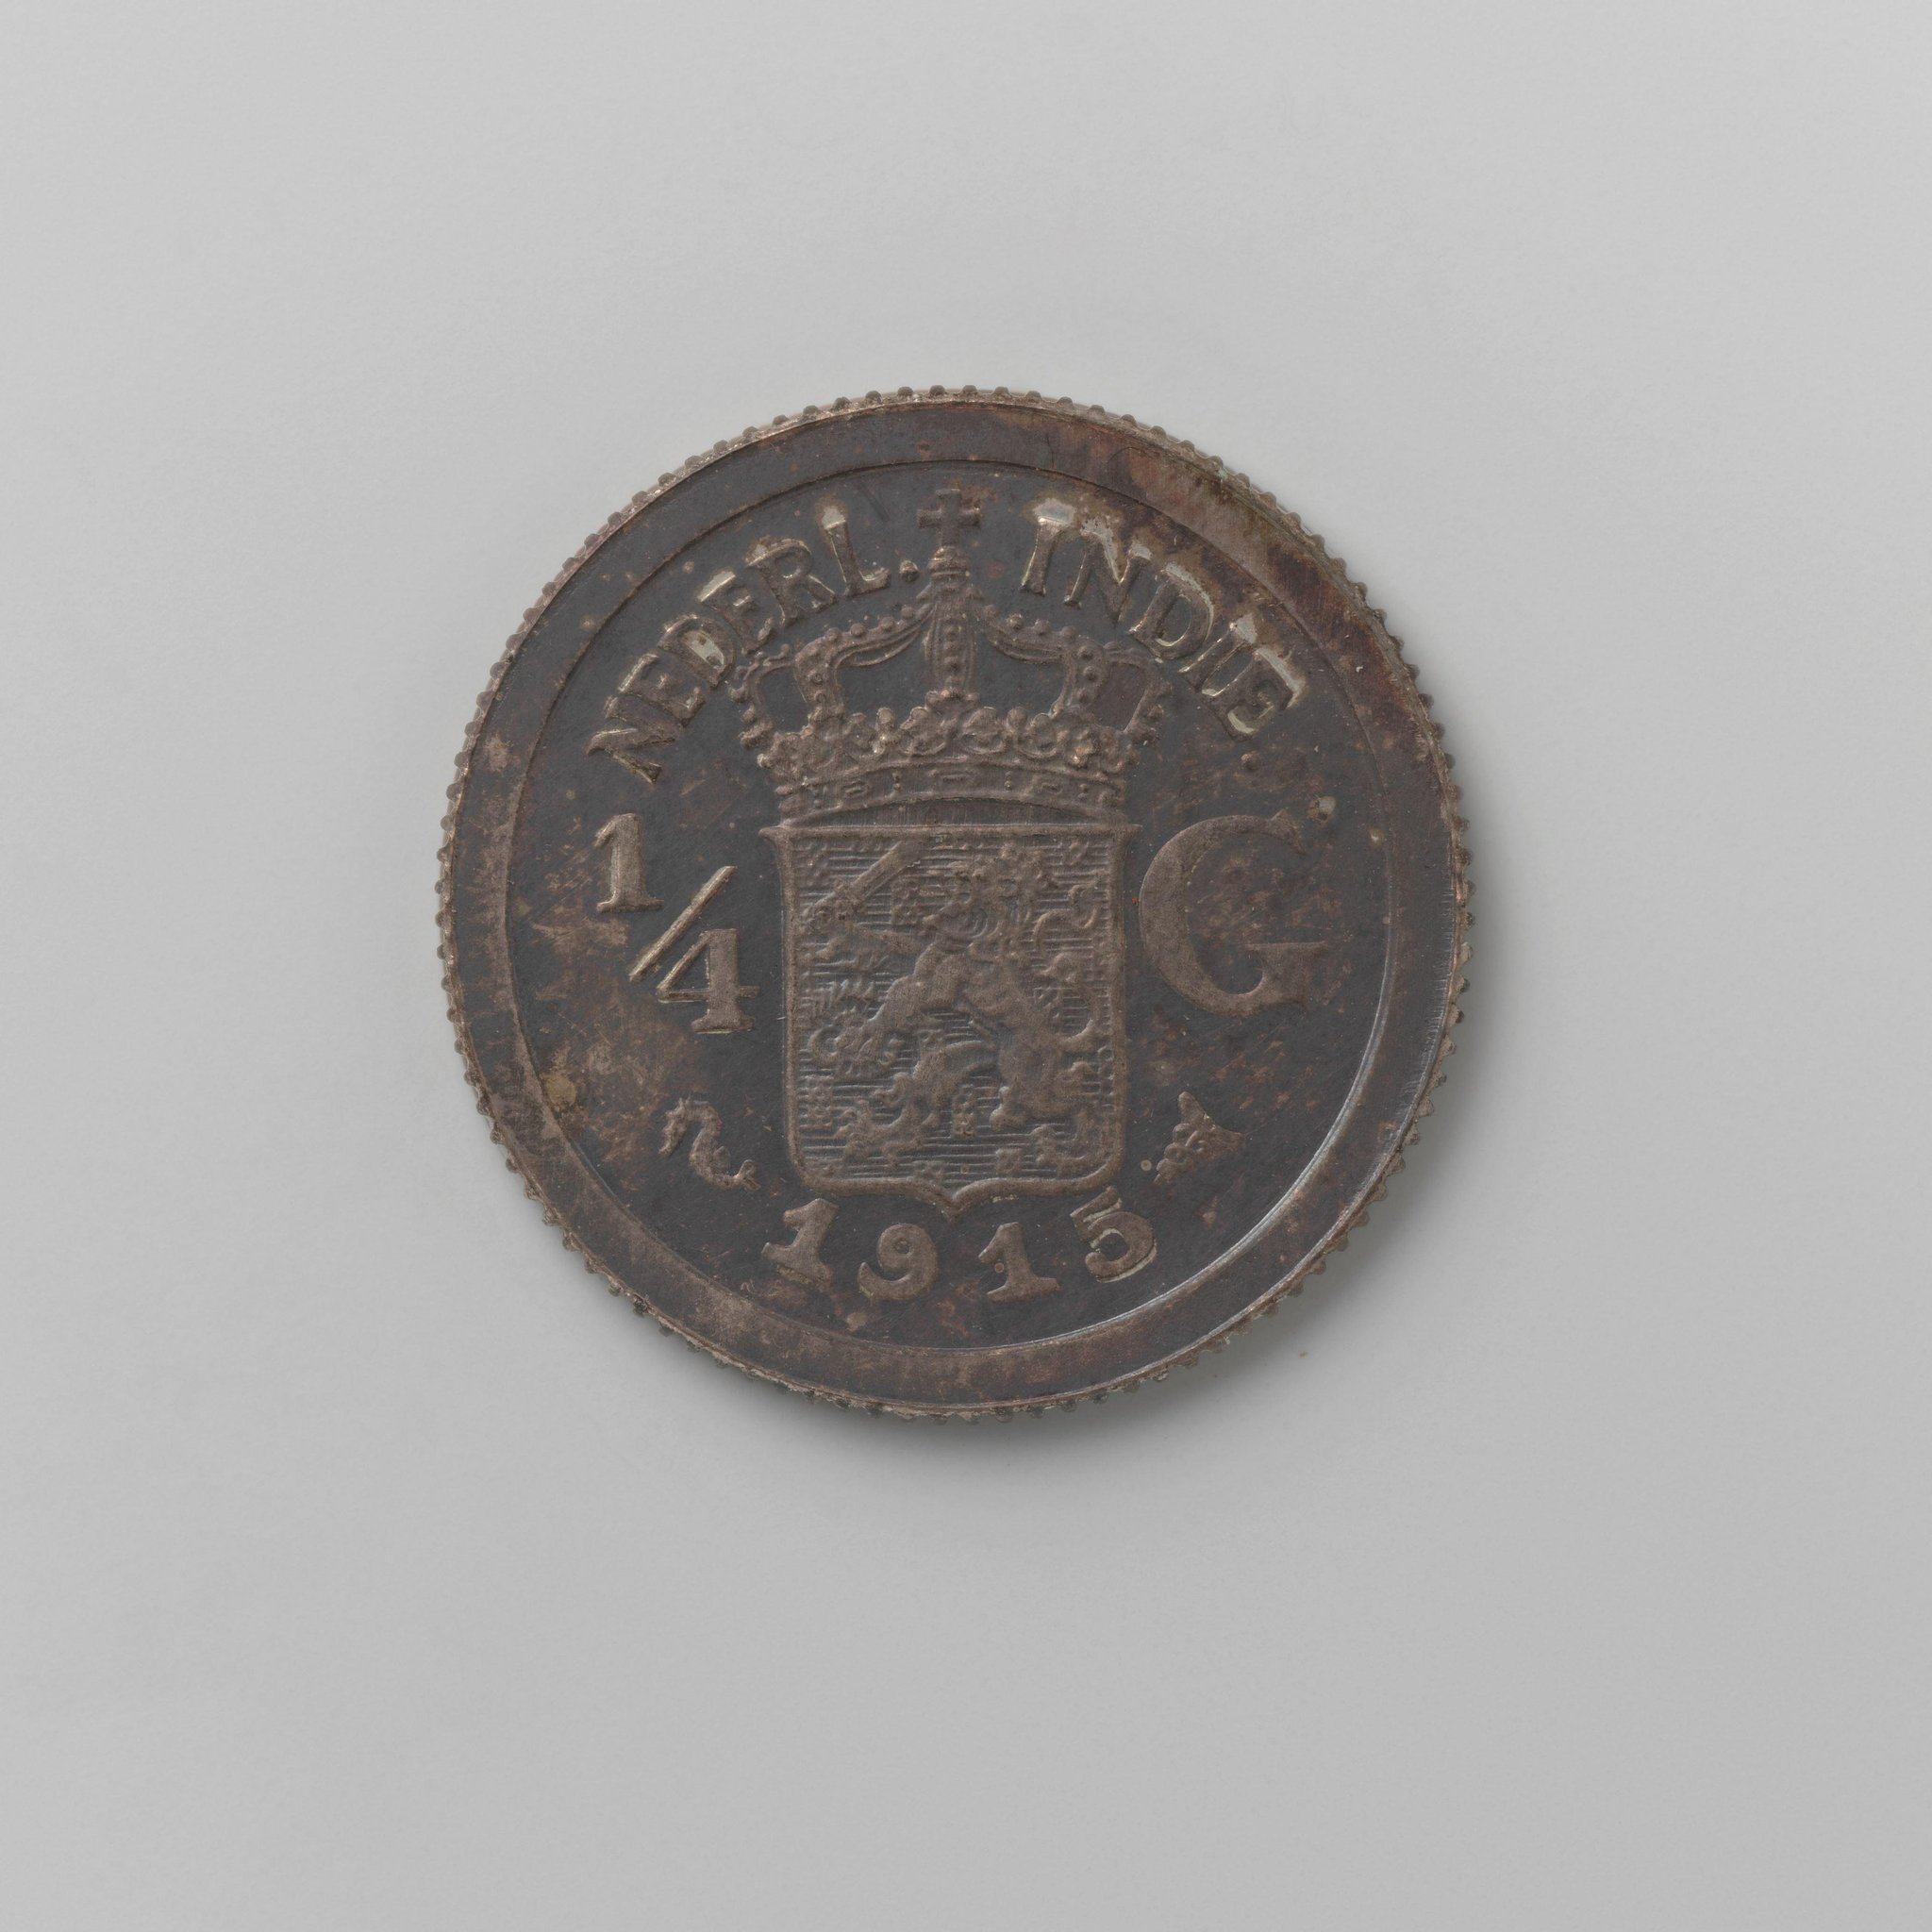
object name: coin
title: Nederlands Indië,1/4 gulden,1915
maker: wilhelmina of the netherlands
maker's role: print maker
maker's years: 1880-1962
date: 1915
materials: silver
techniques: striking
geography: utrecht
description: Zilveren munt. Voorzijde: tussen waarde-aanduiding 1/4 G gekroond rijkswapenschild. Boven kroon landsaanduiding en onder wapenschild jaartal. Keerzijde: drieregelig Maleis opschrift in Arabische tekens, waaromheen tussen zeven uitschietende stralen omschrift in het Javaans. Kartelrand.